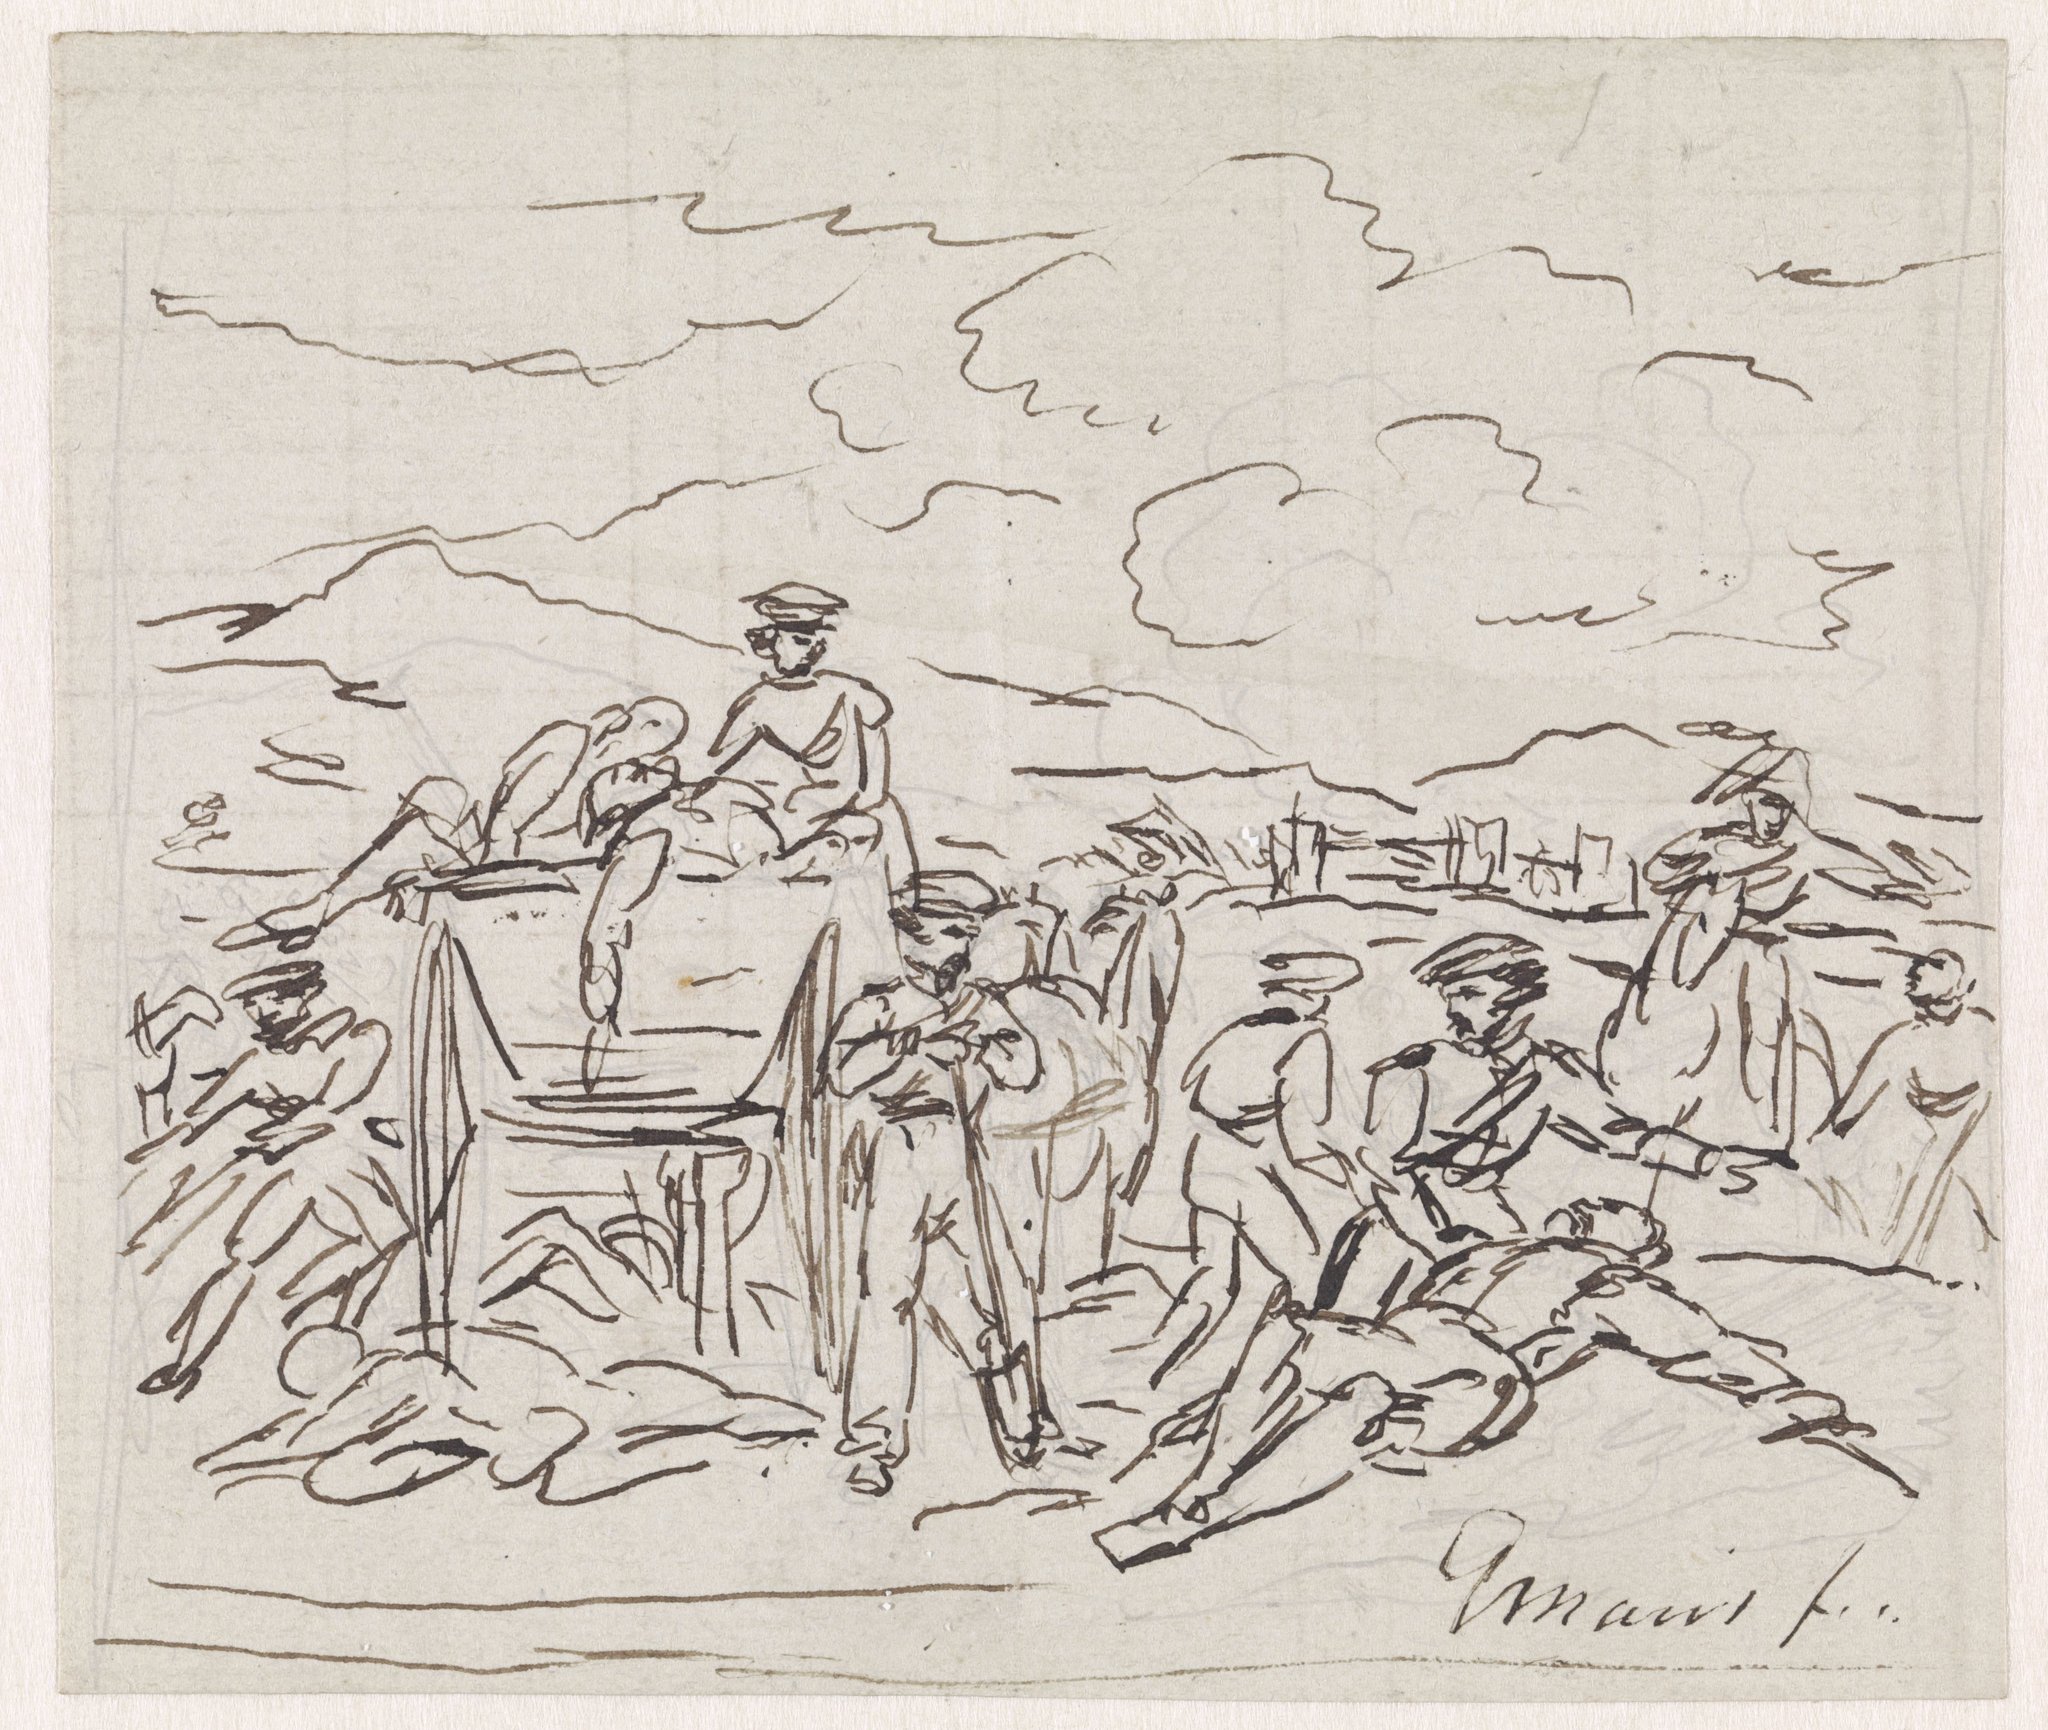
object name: drawing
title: Ambulancewagen verzamelt doden en gewonden van het slagveld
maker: gerardus emaus de micault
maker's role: draughtsman, print maker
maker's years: 1798-1863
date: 1799-1863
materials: ink, paper, pencil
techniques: pen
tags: carrying the sick, wounded and dead off the battle-field, after the battle